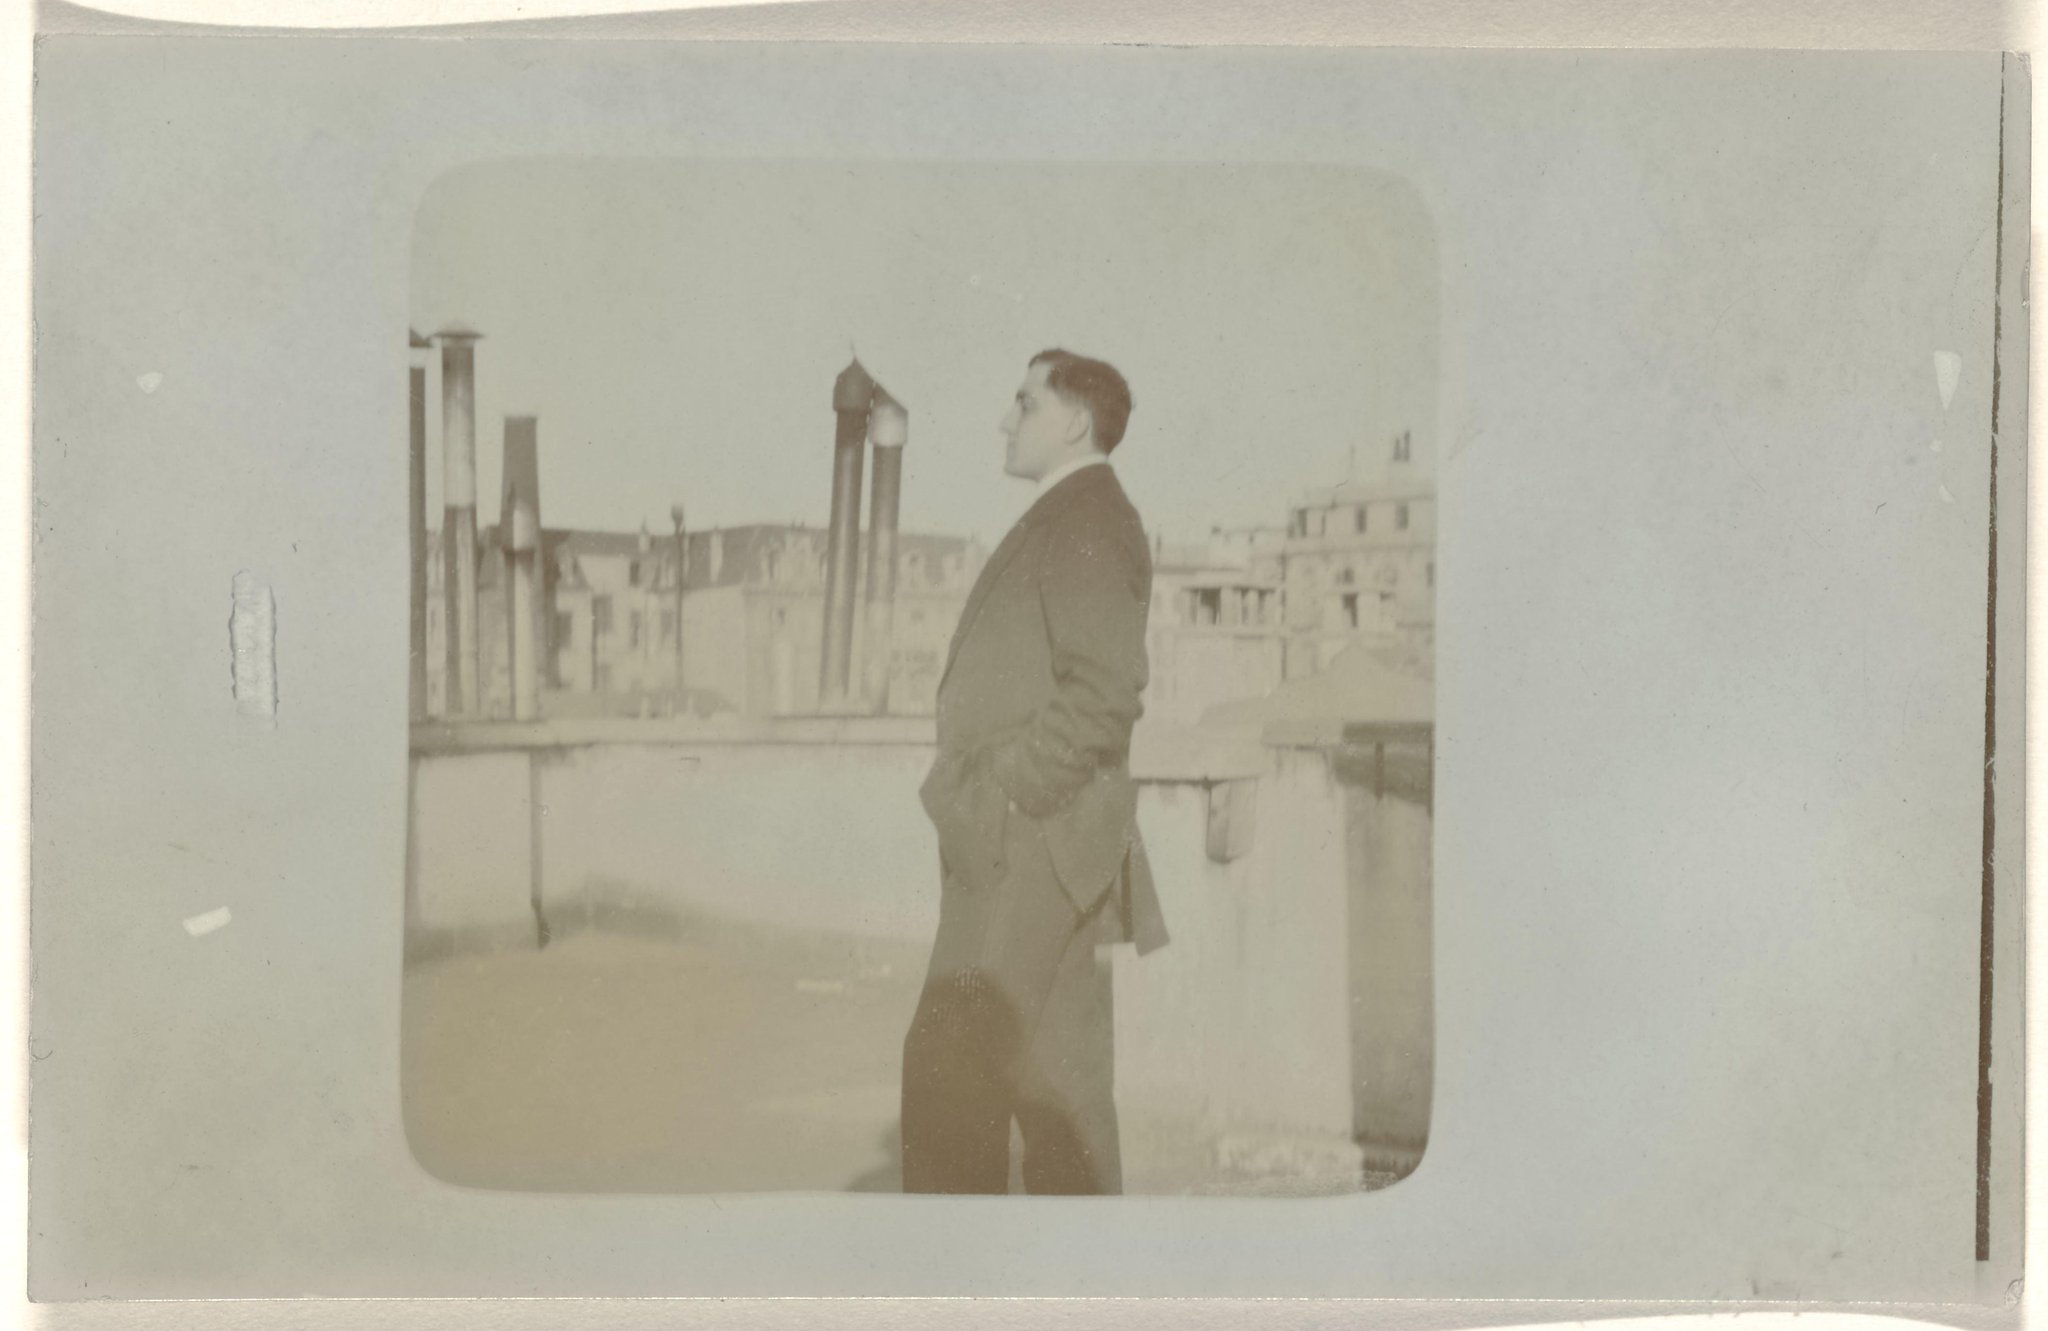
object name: photograph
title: Eugen Wachenheimer op een balkon in Istanbul, 1910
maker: Anonymous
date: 1910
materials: photographic support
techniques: gelatin silver print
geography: istanbul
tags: eugen wachenheimer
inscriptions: inscription: ‘Konstantinopel 1910 Republica Argentina Tarjeta Postal Union Postale Universelle’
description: Eugen Wachenheimer op een balkon in Istanbul.